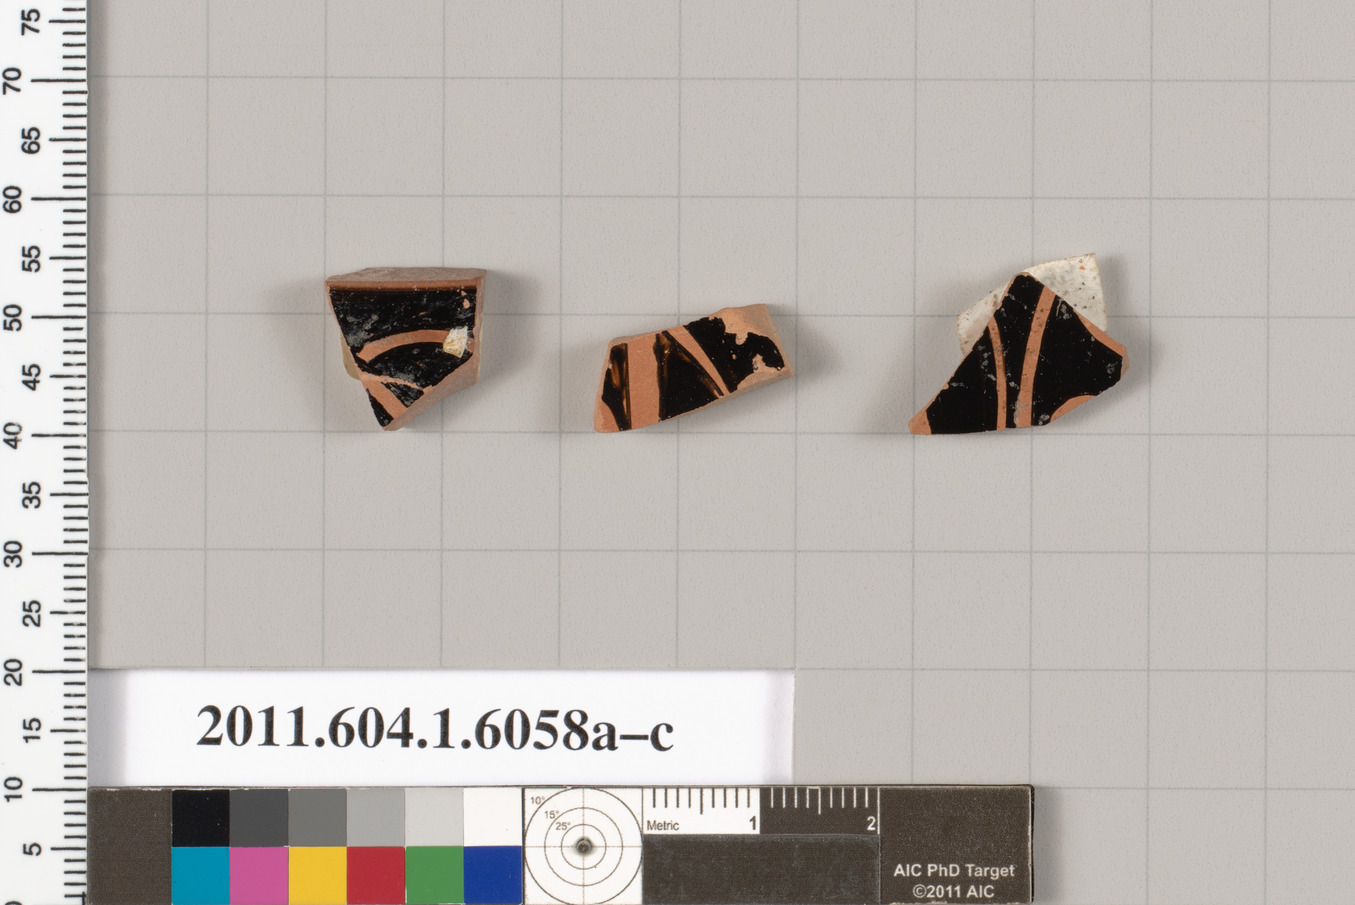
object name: kylix fragment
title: Terracotta fragments of kylikes (drinking cups)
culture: greek, attic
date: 510-500 BCE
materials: terracotta